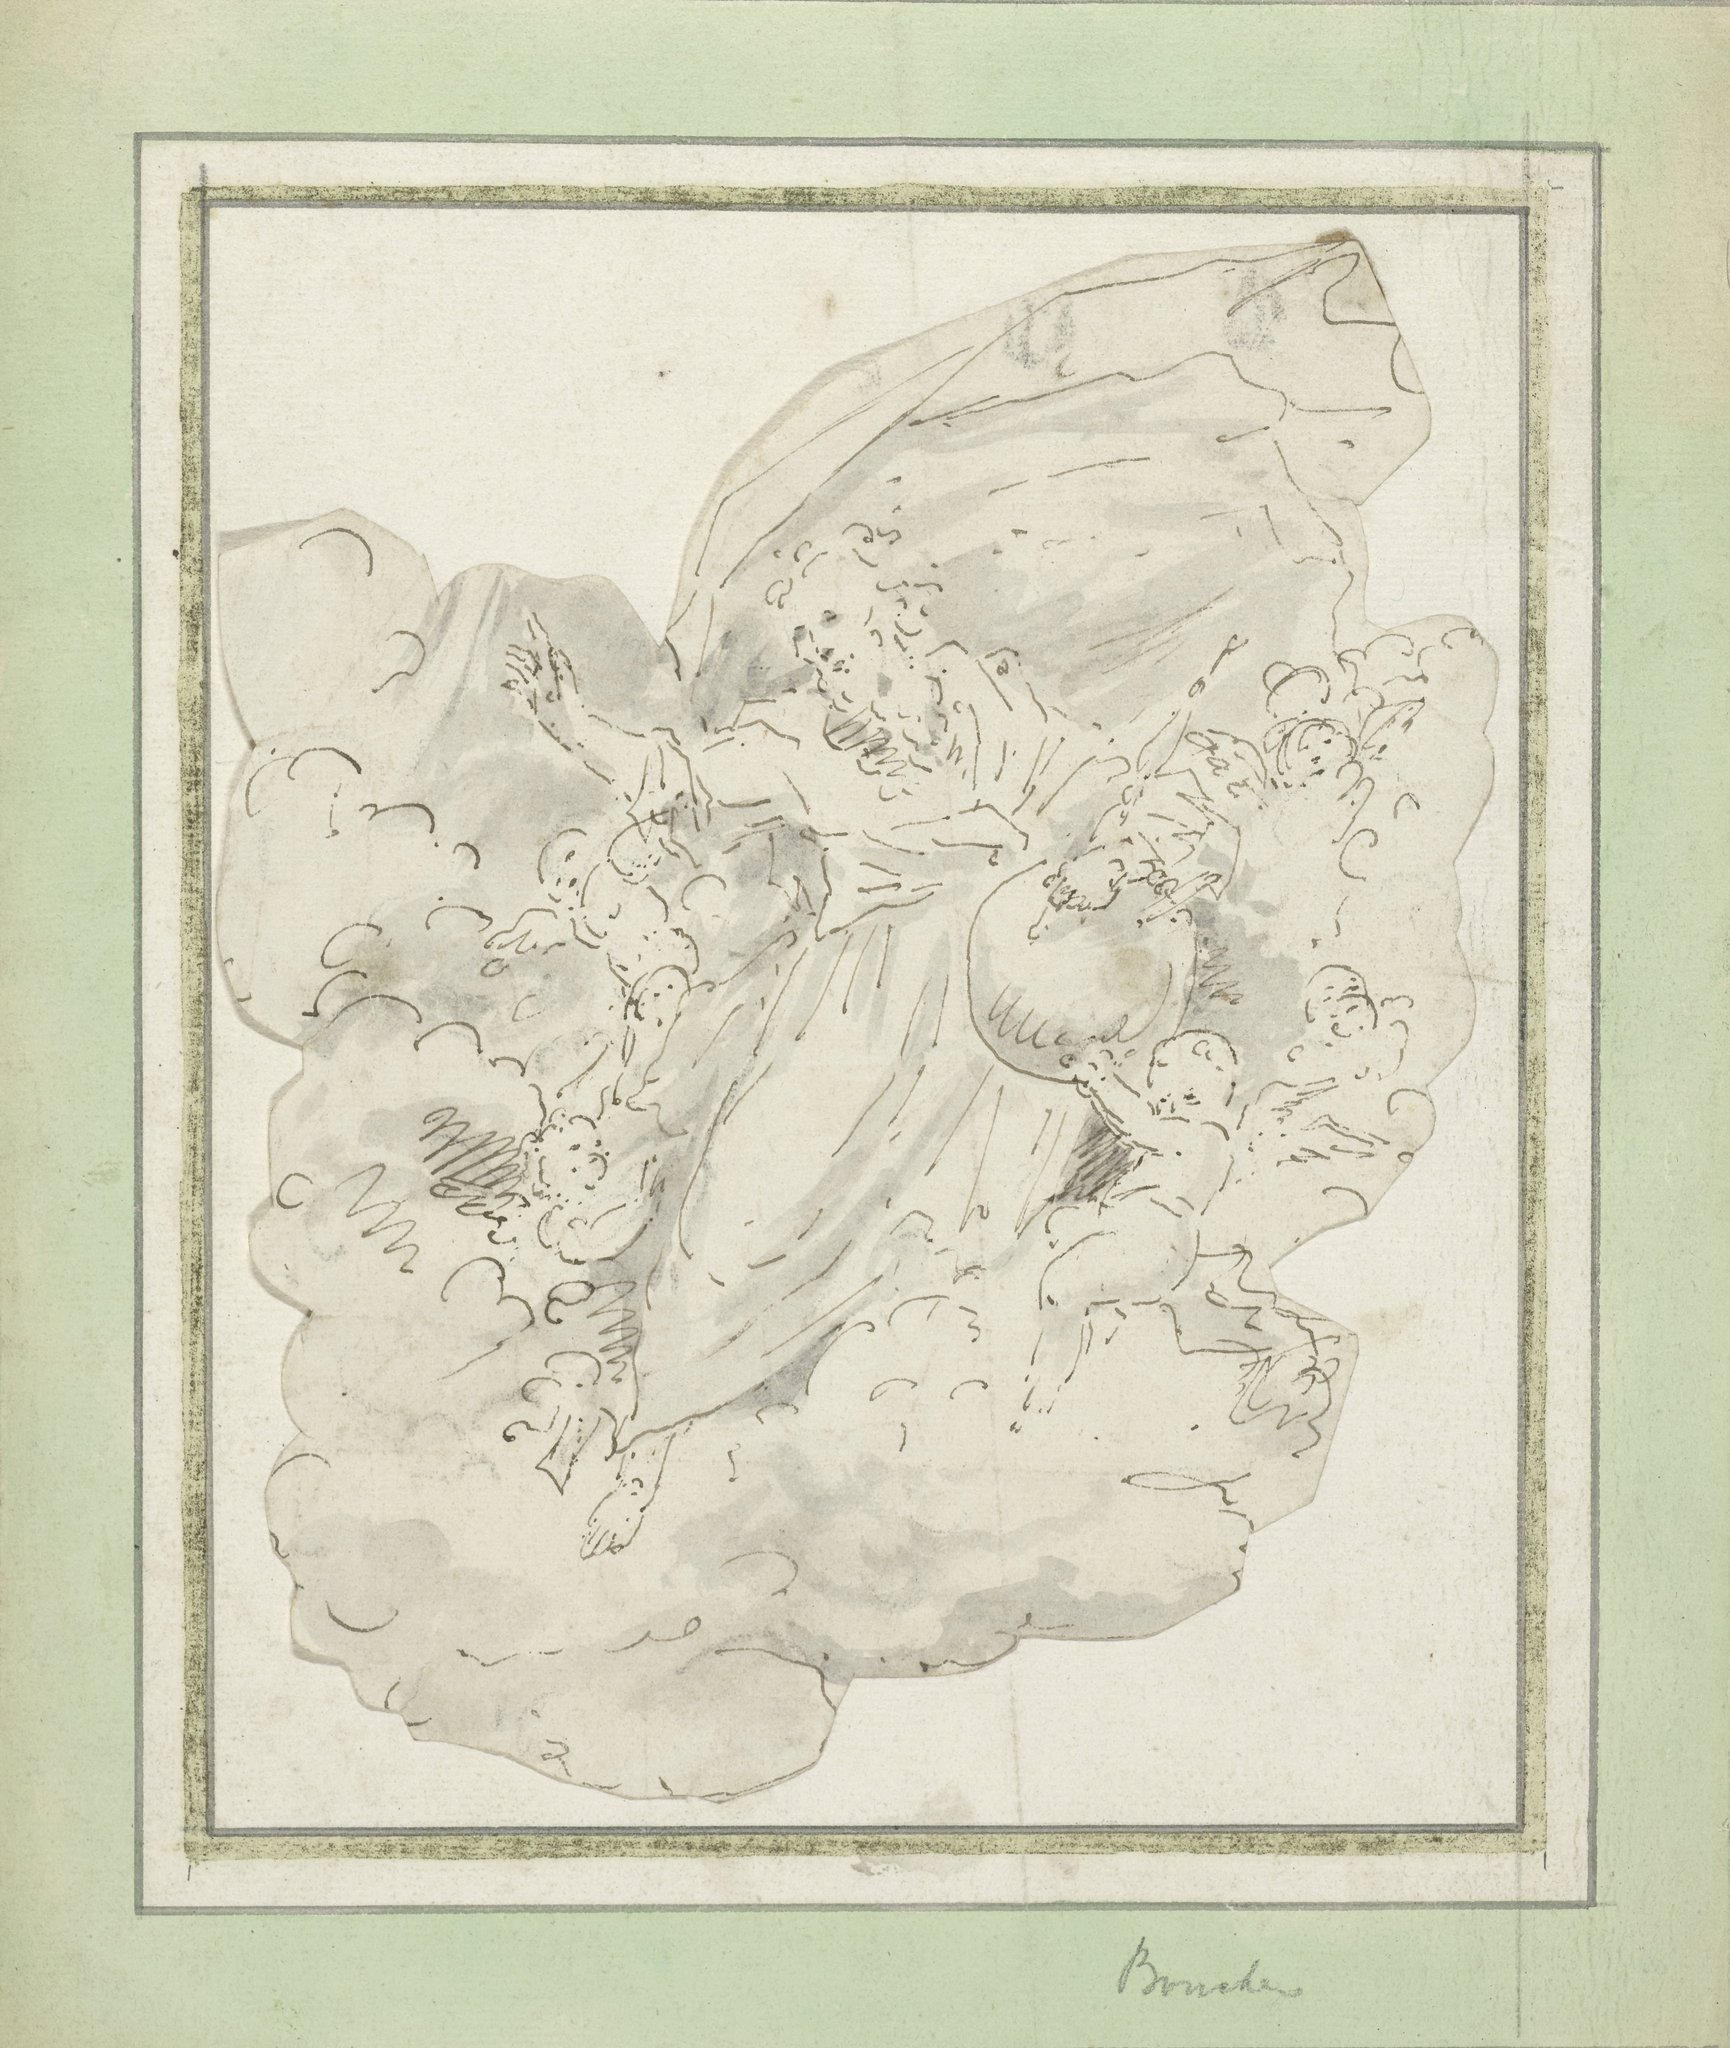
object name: drawing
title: God de Vader temidden van engelen zwevend en zegenend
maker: Anonymous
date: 1700-1800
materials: ink, paper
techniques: brush, pen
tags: god the father represented as human being, usually with crown or tiara or sceptre and/or globe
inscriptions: collector's mark, verso, centre: Lugt 2228, annotation, on the mount, lower left, pencil: ‘Boucher’, annotation, verso, lower right, pencil: ‘214/25’